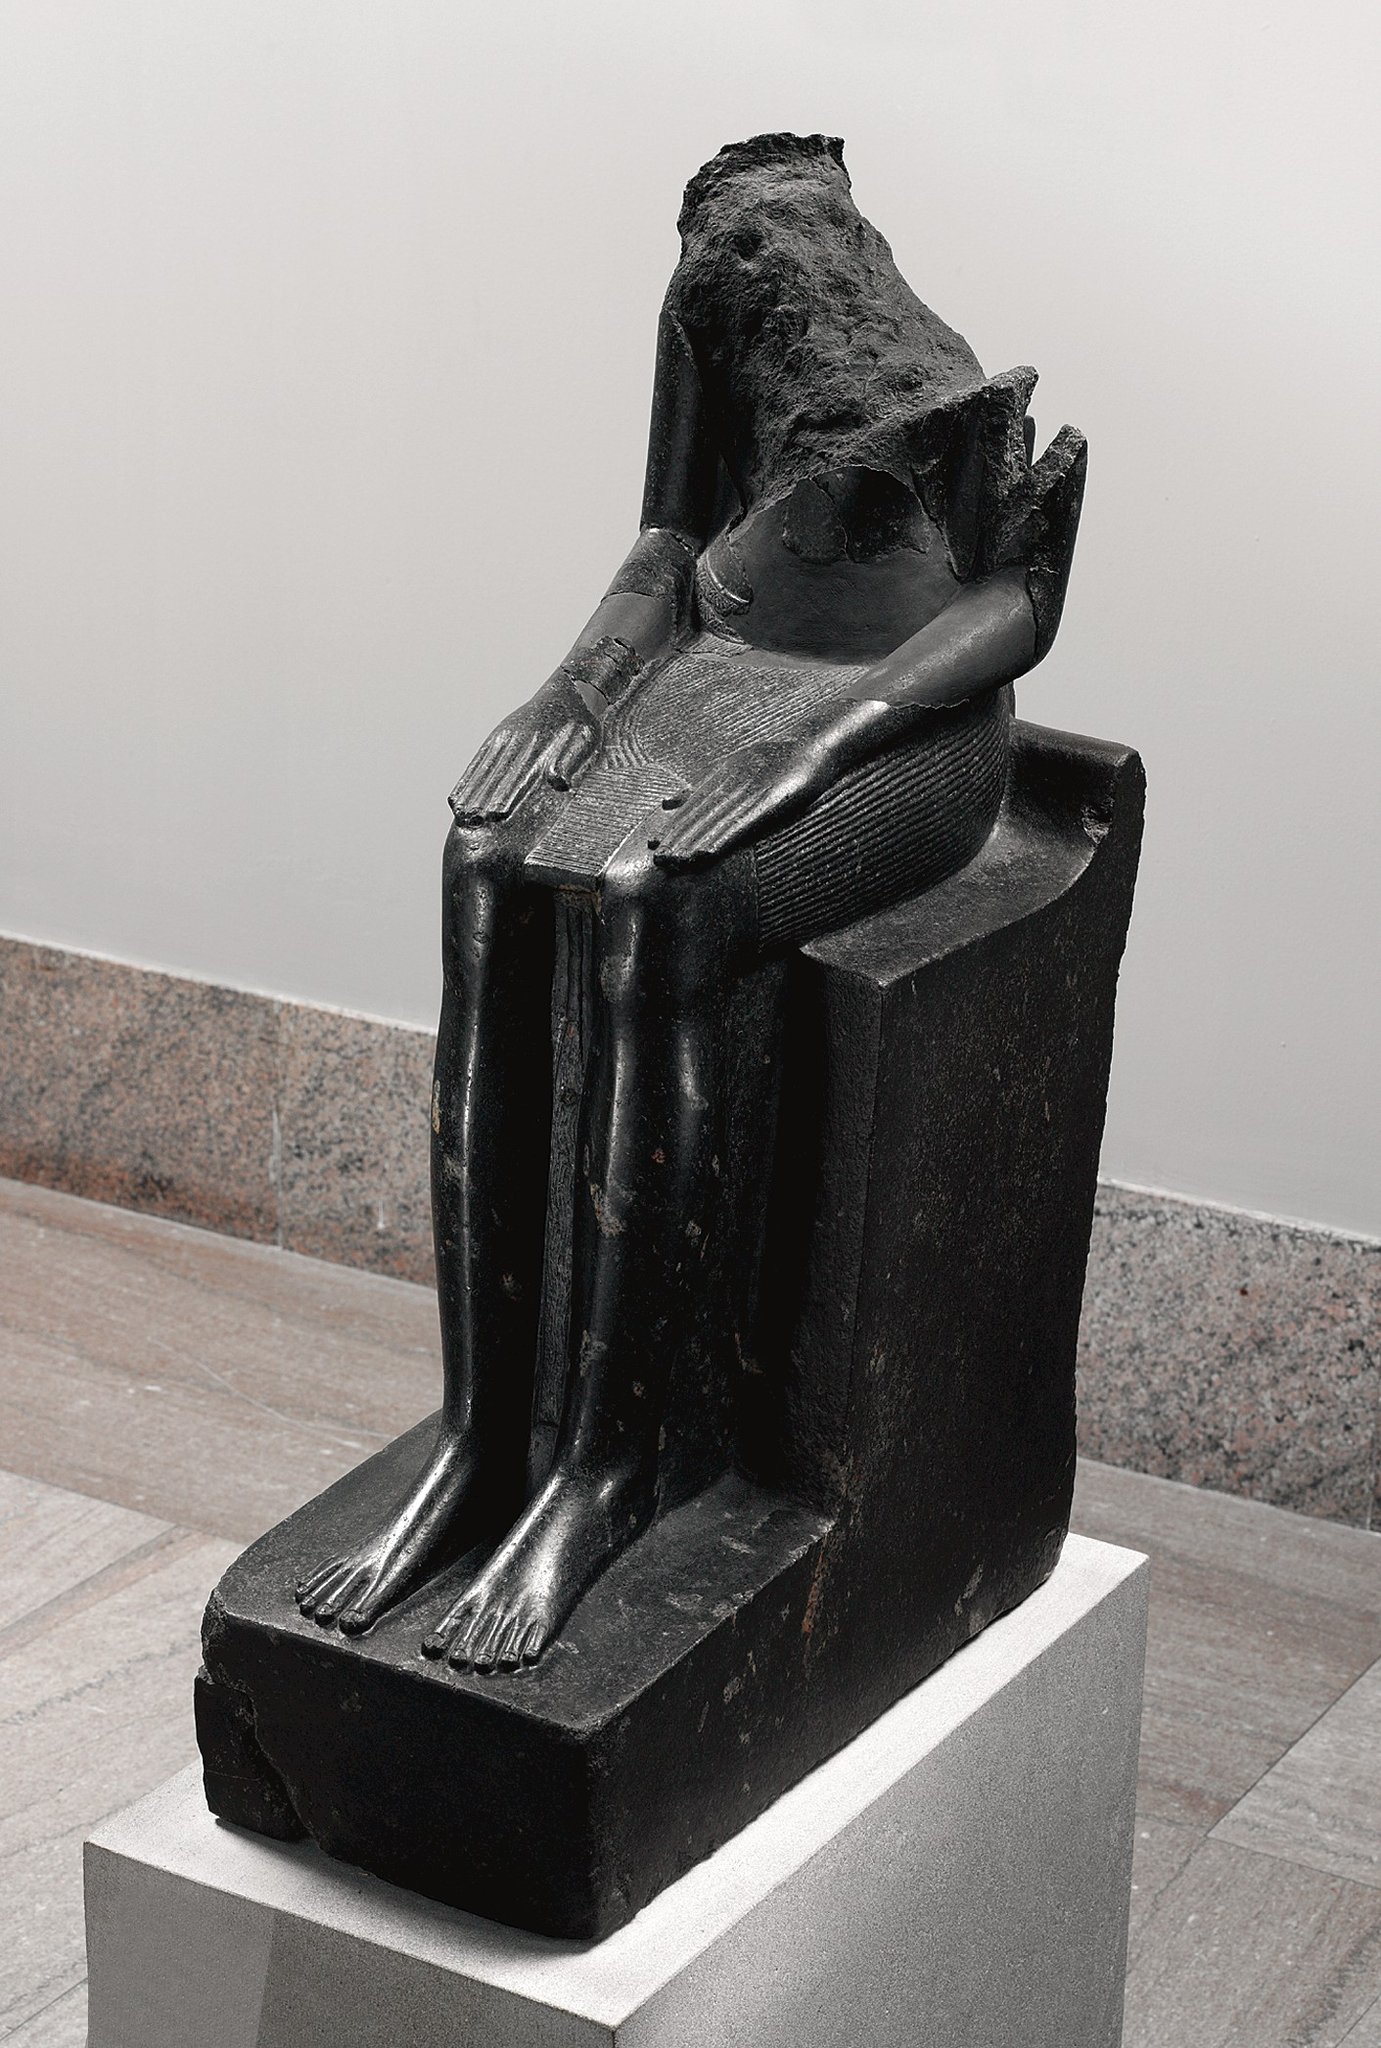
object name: statue, hatshepsut seated, lower part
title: Lower Part of a Statue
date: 1479-1458 BCE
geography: egypt